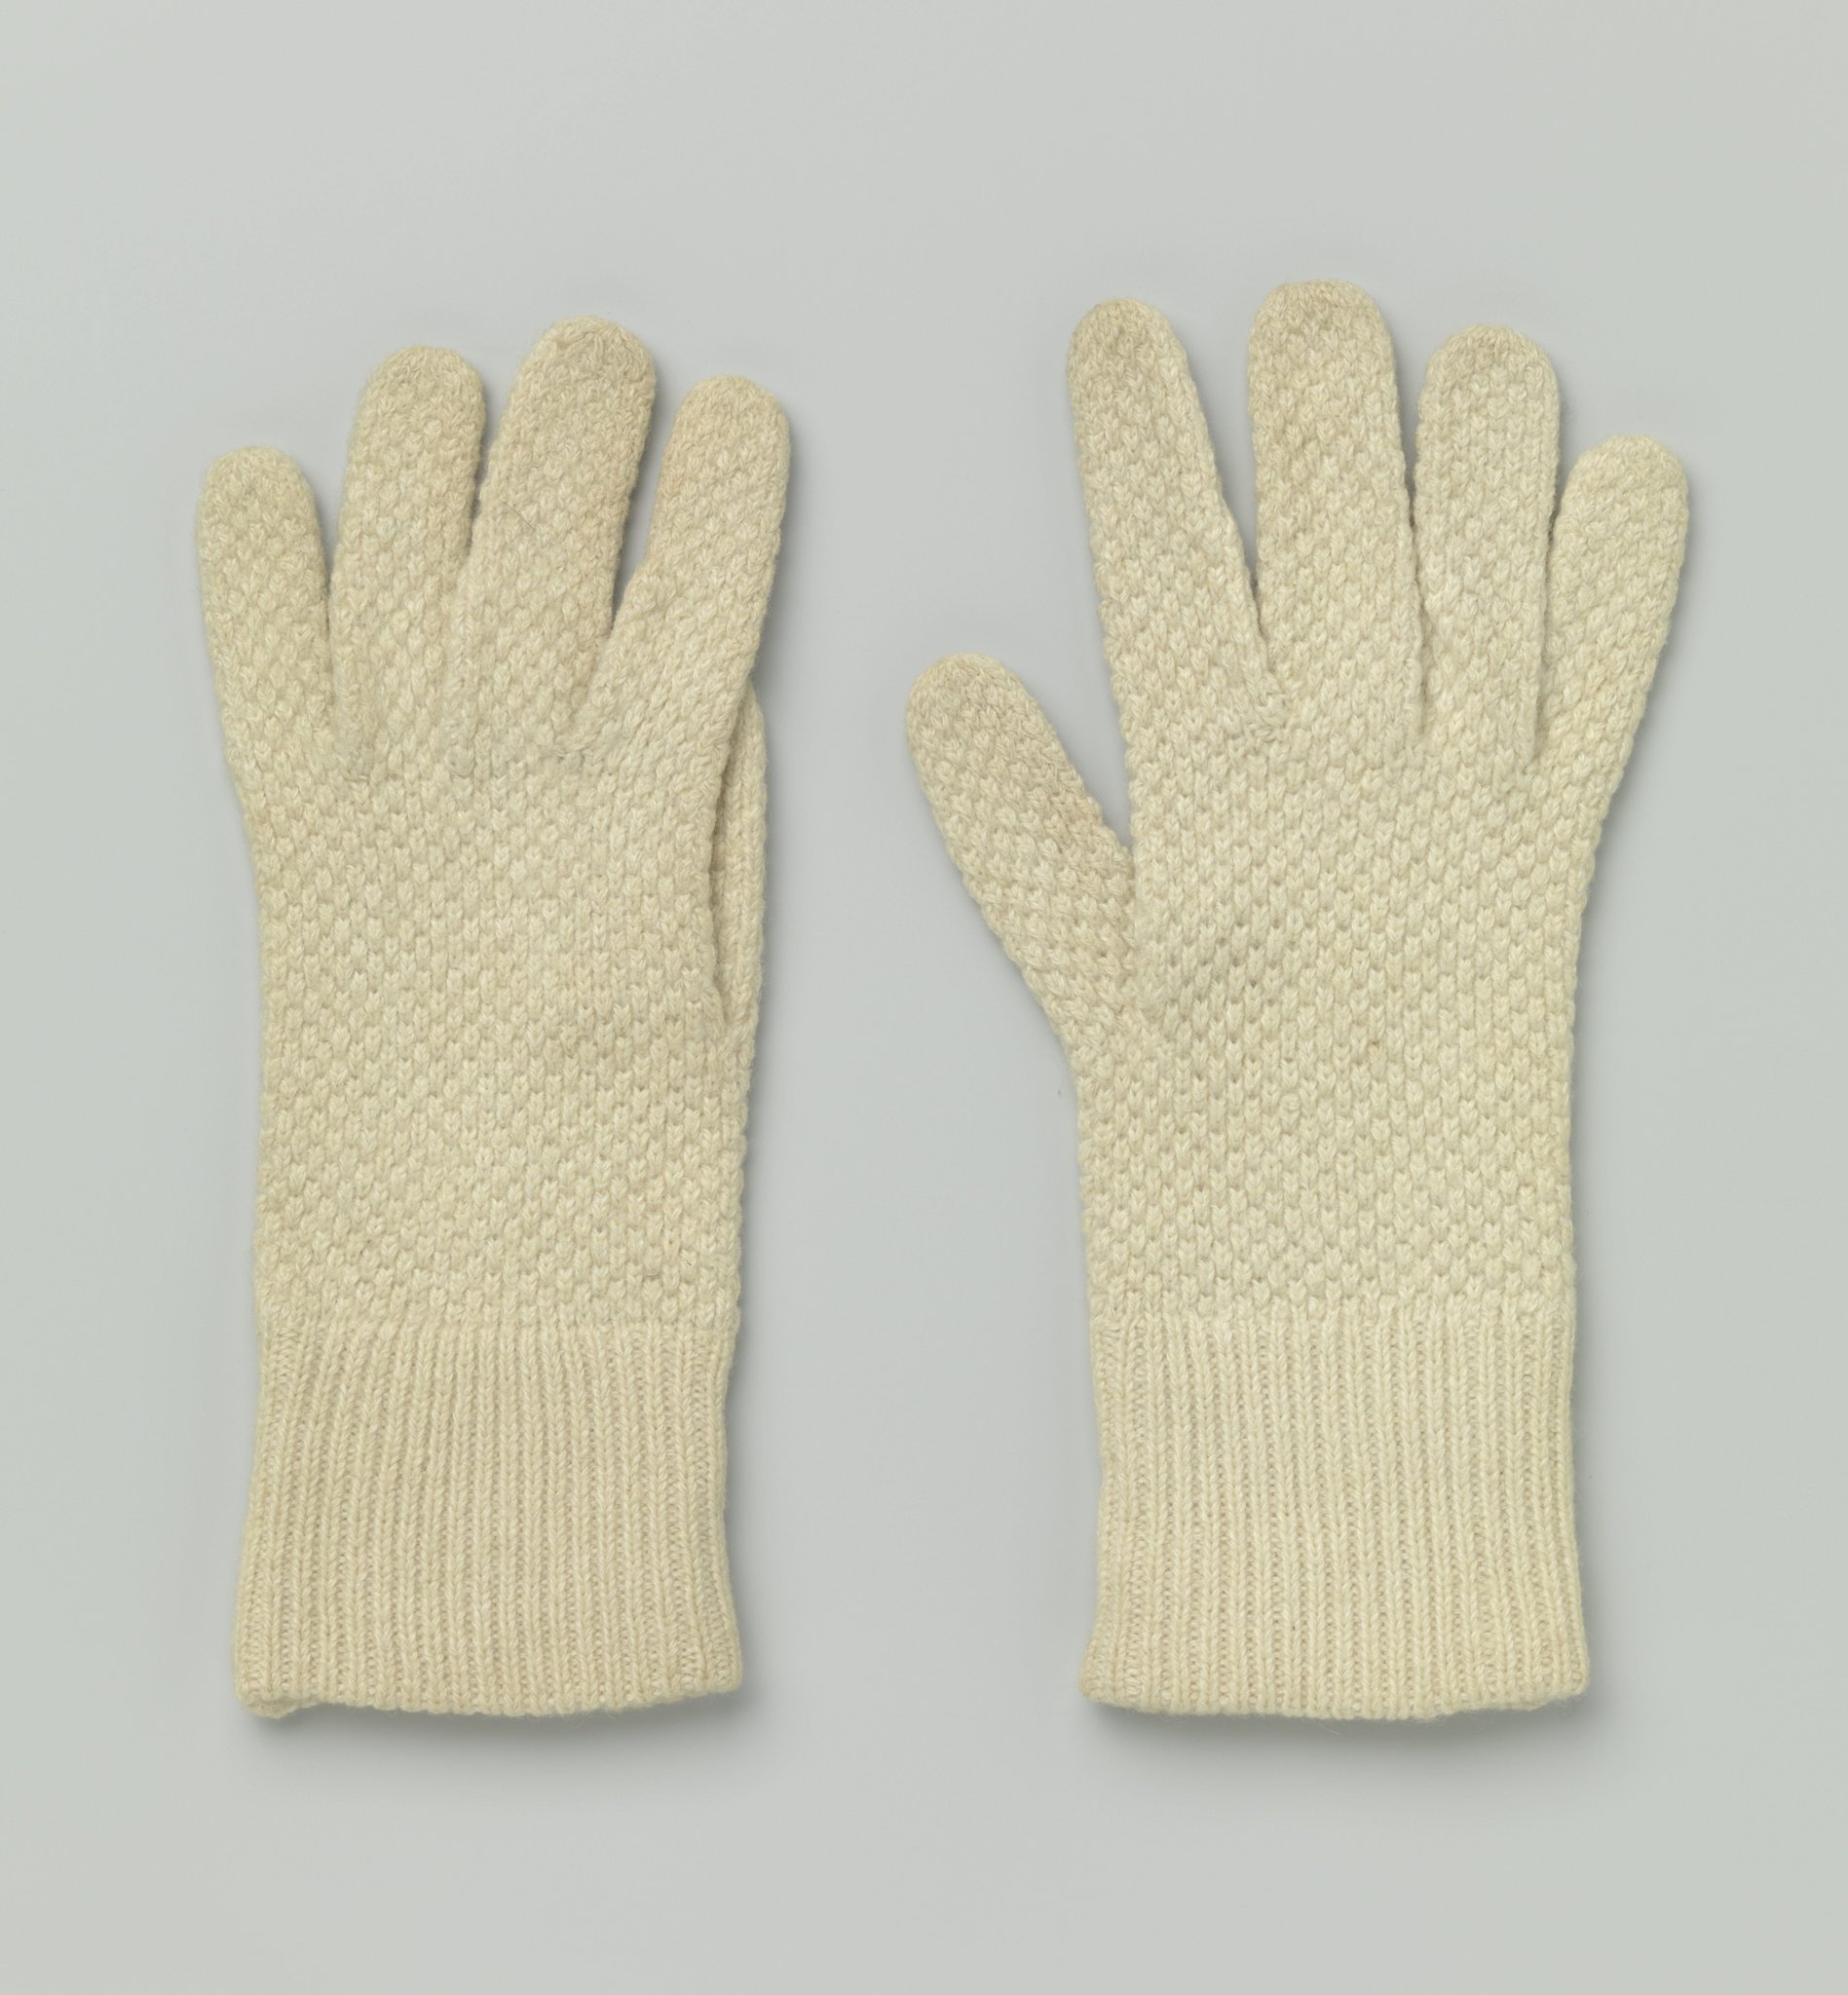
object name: menswear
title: Handschoen van witte wol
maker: Anonymous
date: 1900-1920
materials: wool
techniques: knitting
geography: amsterdam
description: Paar heren schaatshandschoenen van witte gebreide wol, z.g. "Ringwood". Model: Kort, met dubbel en gesloten polsboord. Patroon: Gerstenkorrel-Breisel.